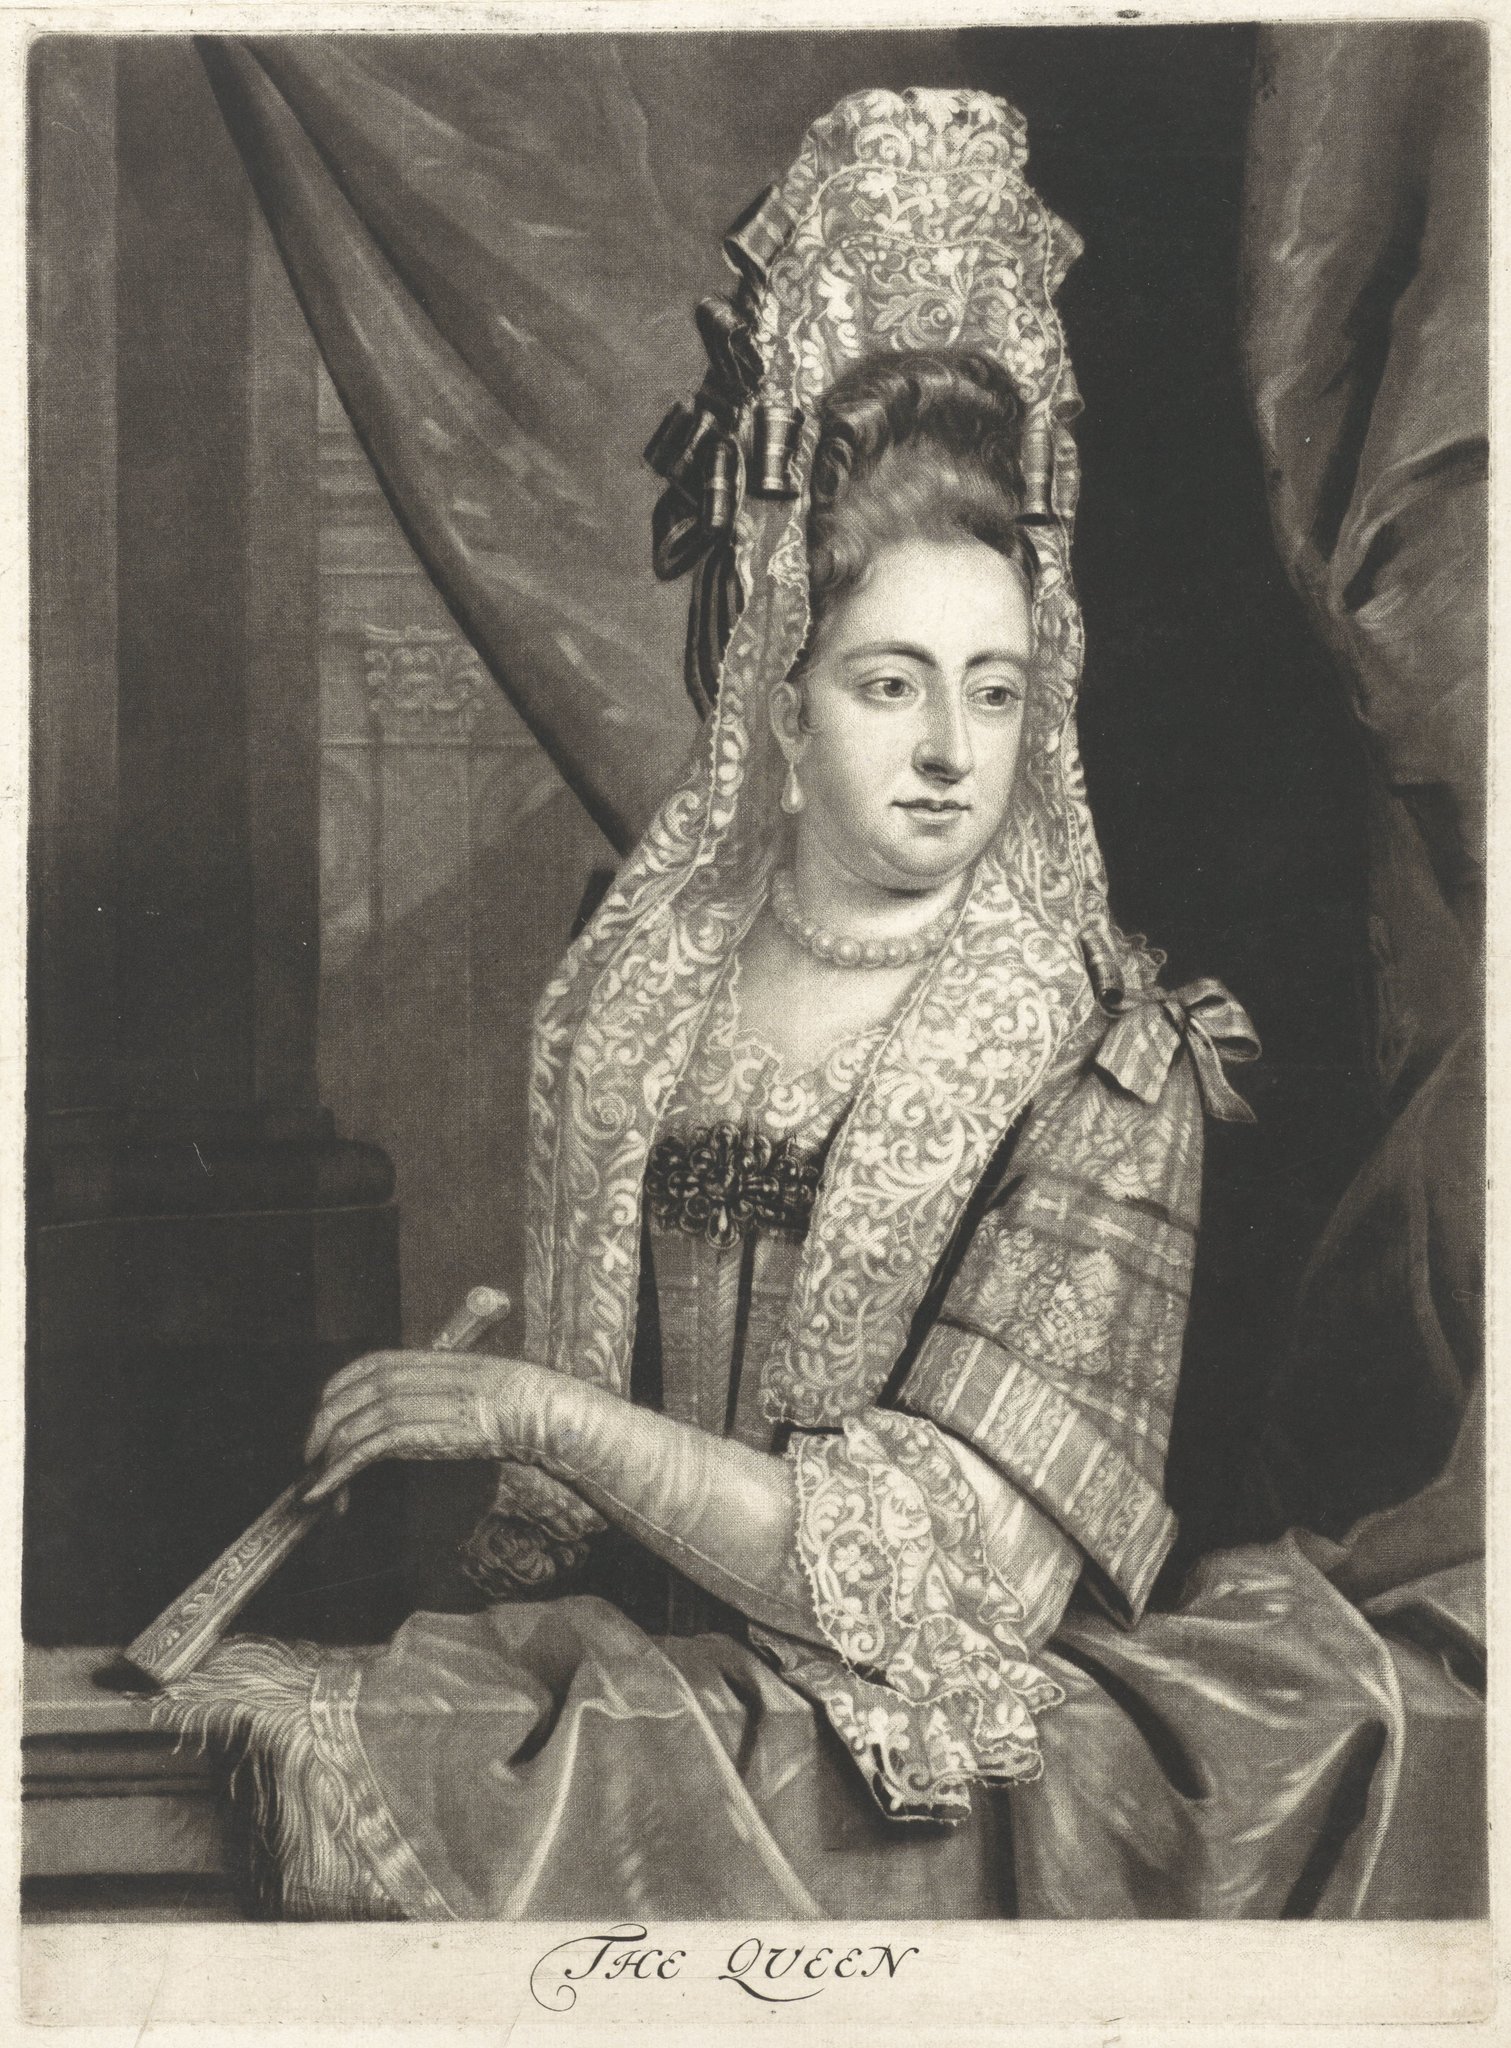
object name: print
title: The Queen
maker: jacob gole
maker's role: print maker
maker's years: 1660-1724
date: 1689-1724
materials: paper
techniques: engraving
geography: amsterdam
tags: maria ii stuart (koningin van engeland, schotland en ierland), ear-rings (+ women's clothes), styles of hairdress (with name) - aa - ~ women, fan, head-gear: fontange (+ women's clothes), necklace (+ women's clothes)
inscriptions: collector's mark: Lugt 2228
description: Maria II Stuart, koningin van Engeland en Schotland, echtgenote van stadhouder-koning Willem III. Ze leunt op een balustrade en draagt een hoofdtooi van kant met strikken. In de hand een waaier.